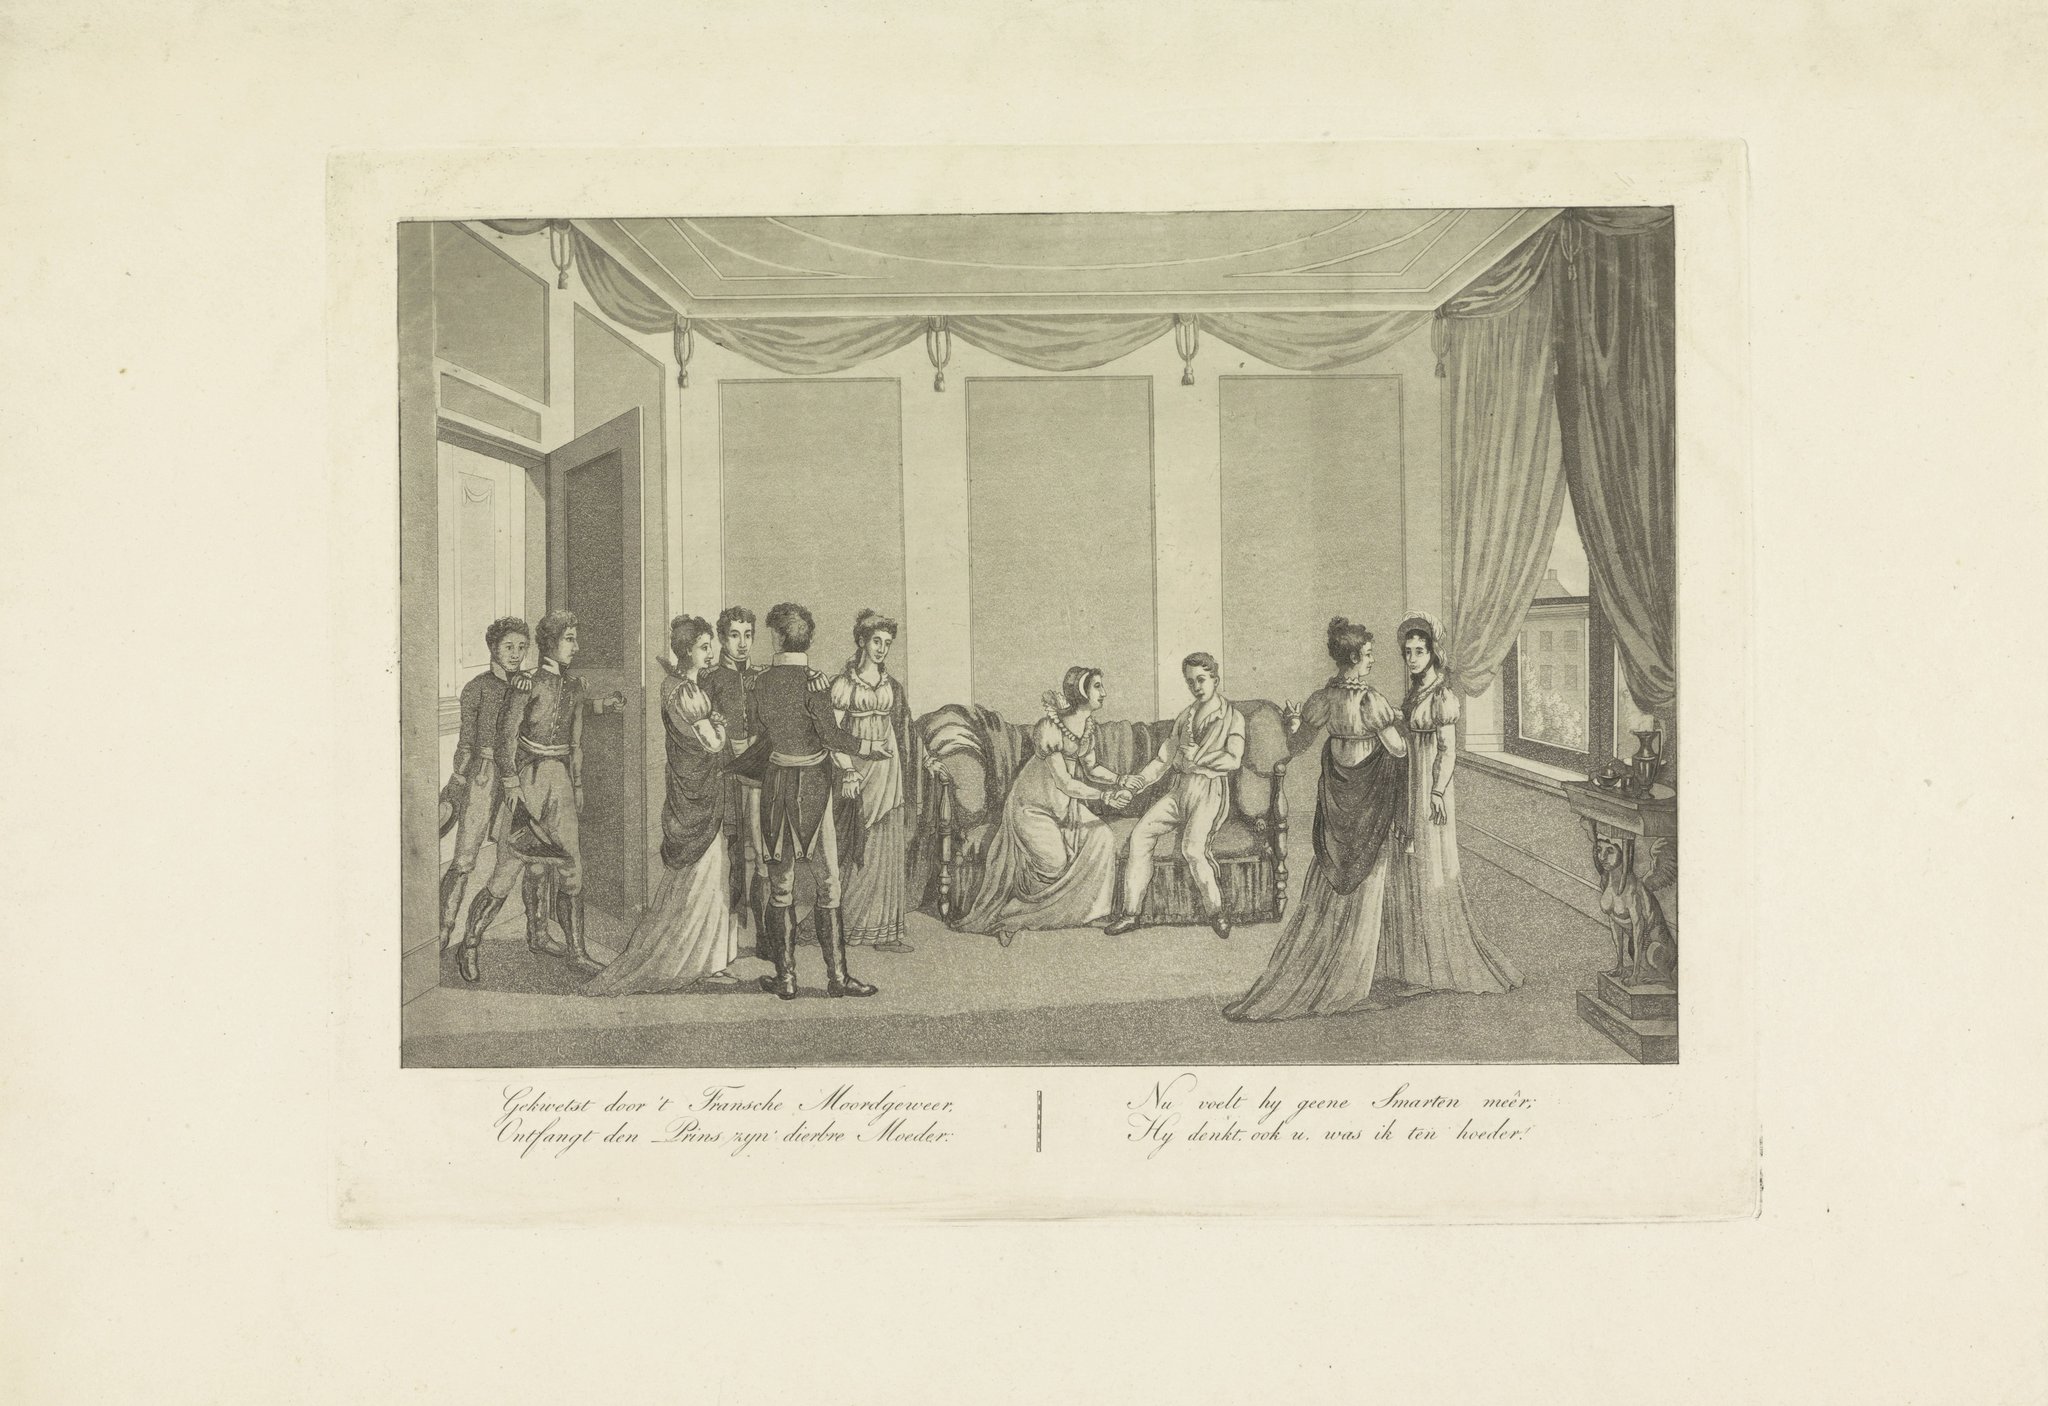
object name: print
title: Gekwetst door 't Fransche Moordgeweer (...)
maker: Anonymous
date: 1815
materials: paper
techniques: aquatint, etching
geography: netherlands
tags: william ii of the netherlands, berlin, painter, draughtsman, wilhelmina of prussia (princess of orange), medical aid and nursing of the sick and wounded, visiting the sick in hospital, waterloo, brussels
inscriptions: collector's mark: Lugt 2228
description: De koningin Wilhelmina van Pruisen bezoekt te Brussel haar zoon Willem Frederik George, prins van Oranje, die gewond is geraakt tijdens de slag bij Waterloo op 18 juni 1815. In het onderschrift een vierregelig vers. Zie ook pendant.